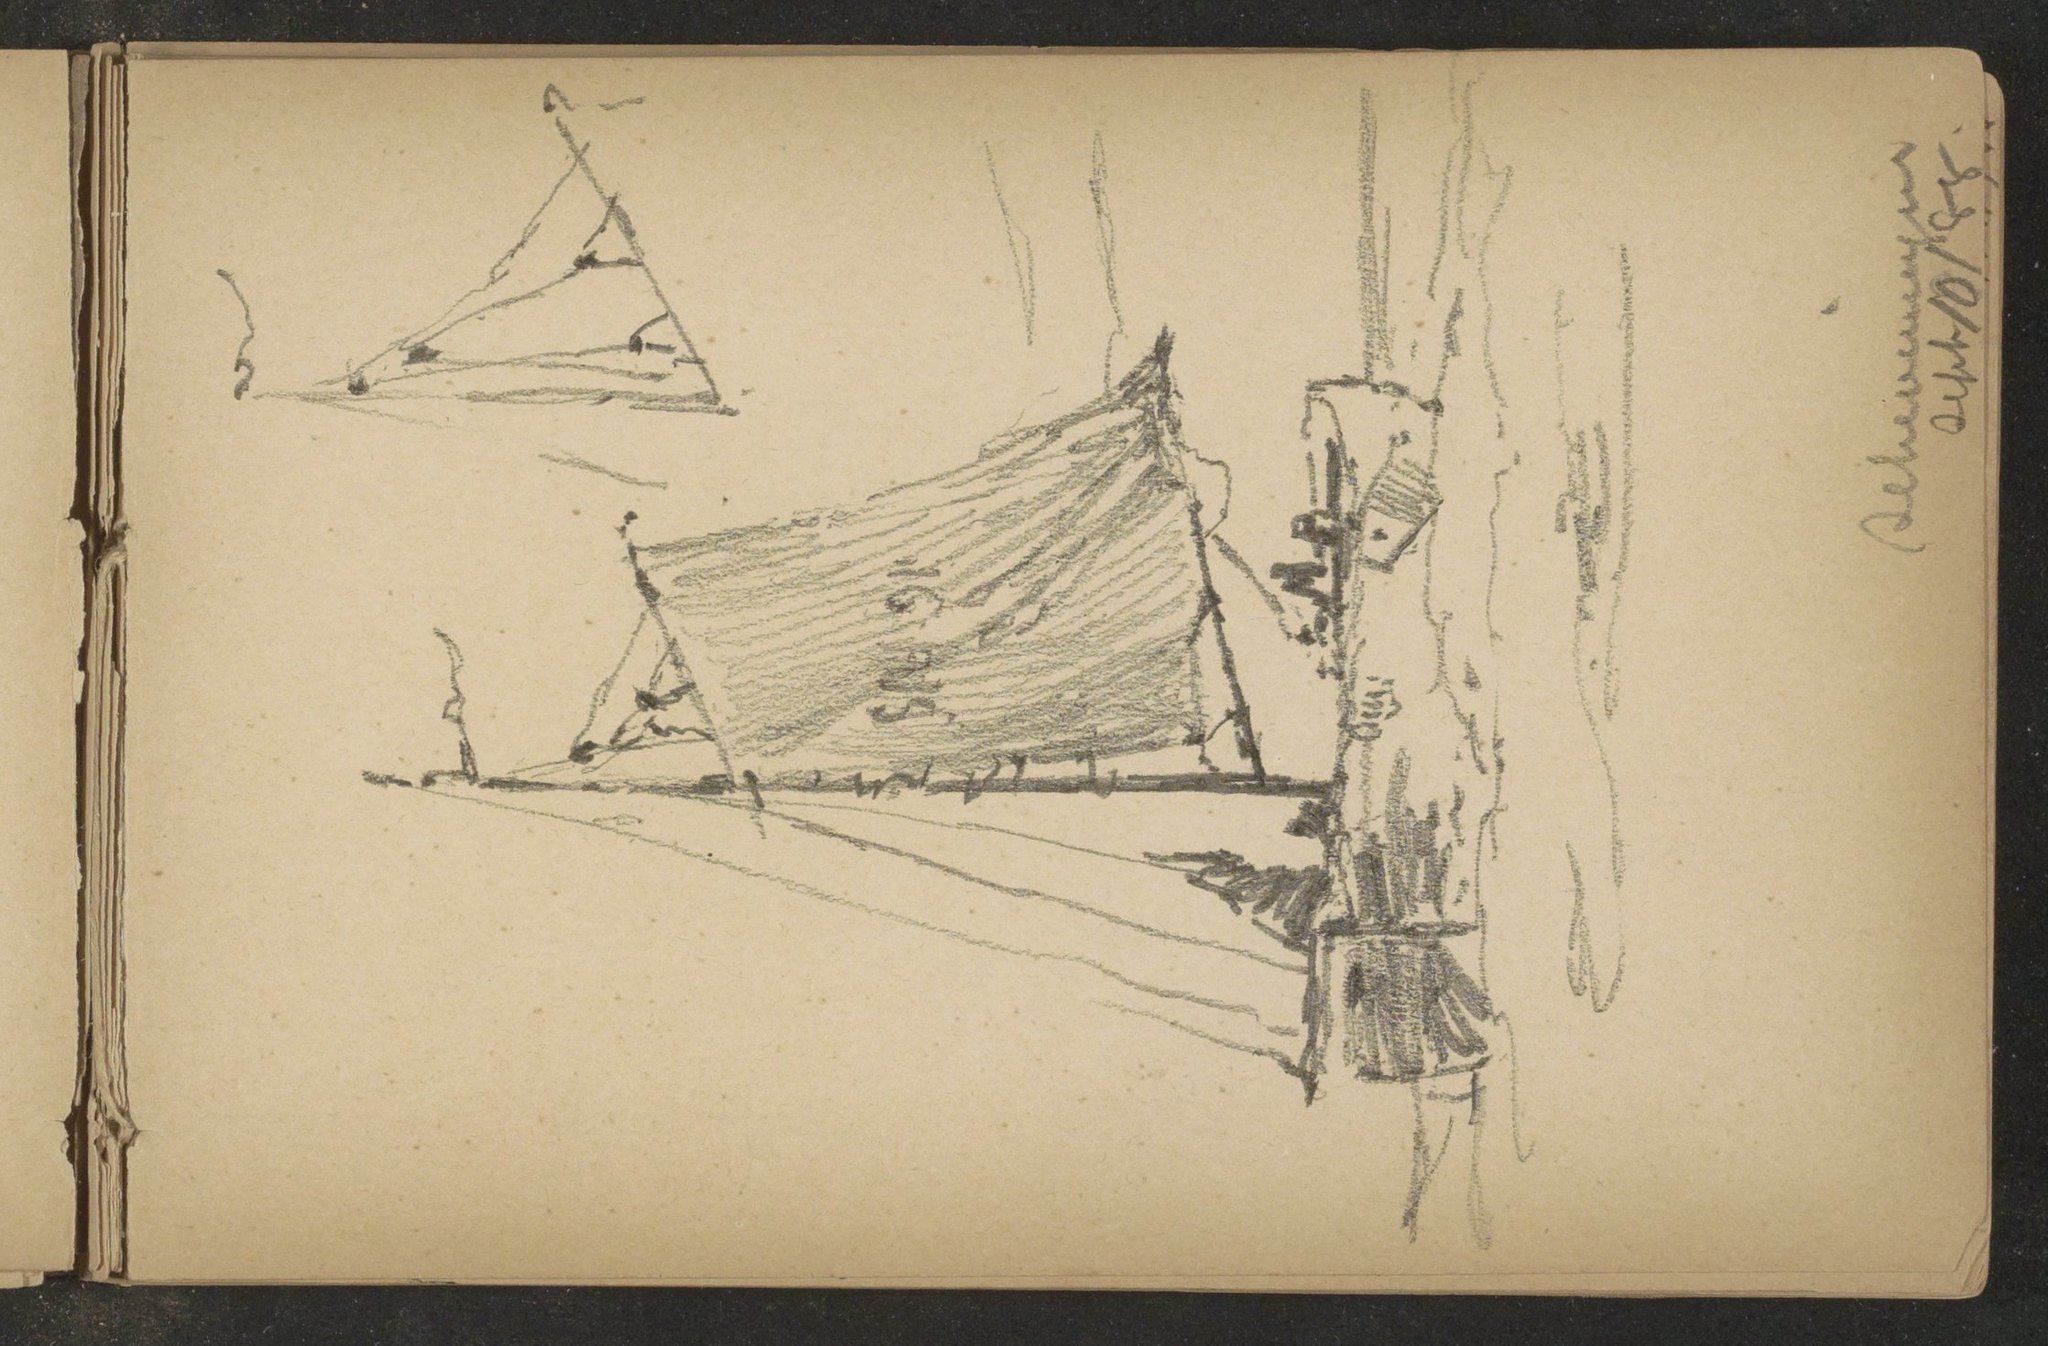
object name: sketchbook leaf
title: Zeilboot voor de kust van Scheveningen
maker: alexander shilling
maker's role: draughtsman, print maker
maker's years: 1859-1937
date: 1809-1888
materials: paper, pencil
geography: scheveningen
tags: sailing-ship, sailing-boat, landscapes with waters, waterscapes, seascapes (in the temperate zone)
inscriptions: date and inscription: ‘Scheveningen/ sept19/88.’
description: Tevens een studie van een mast. Blad 9 recto uit een schetsboek met 34 bladen.